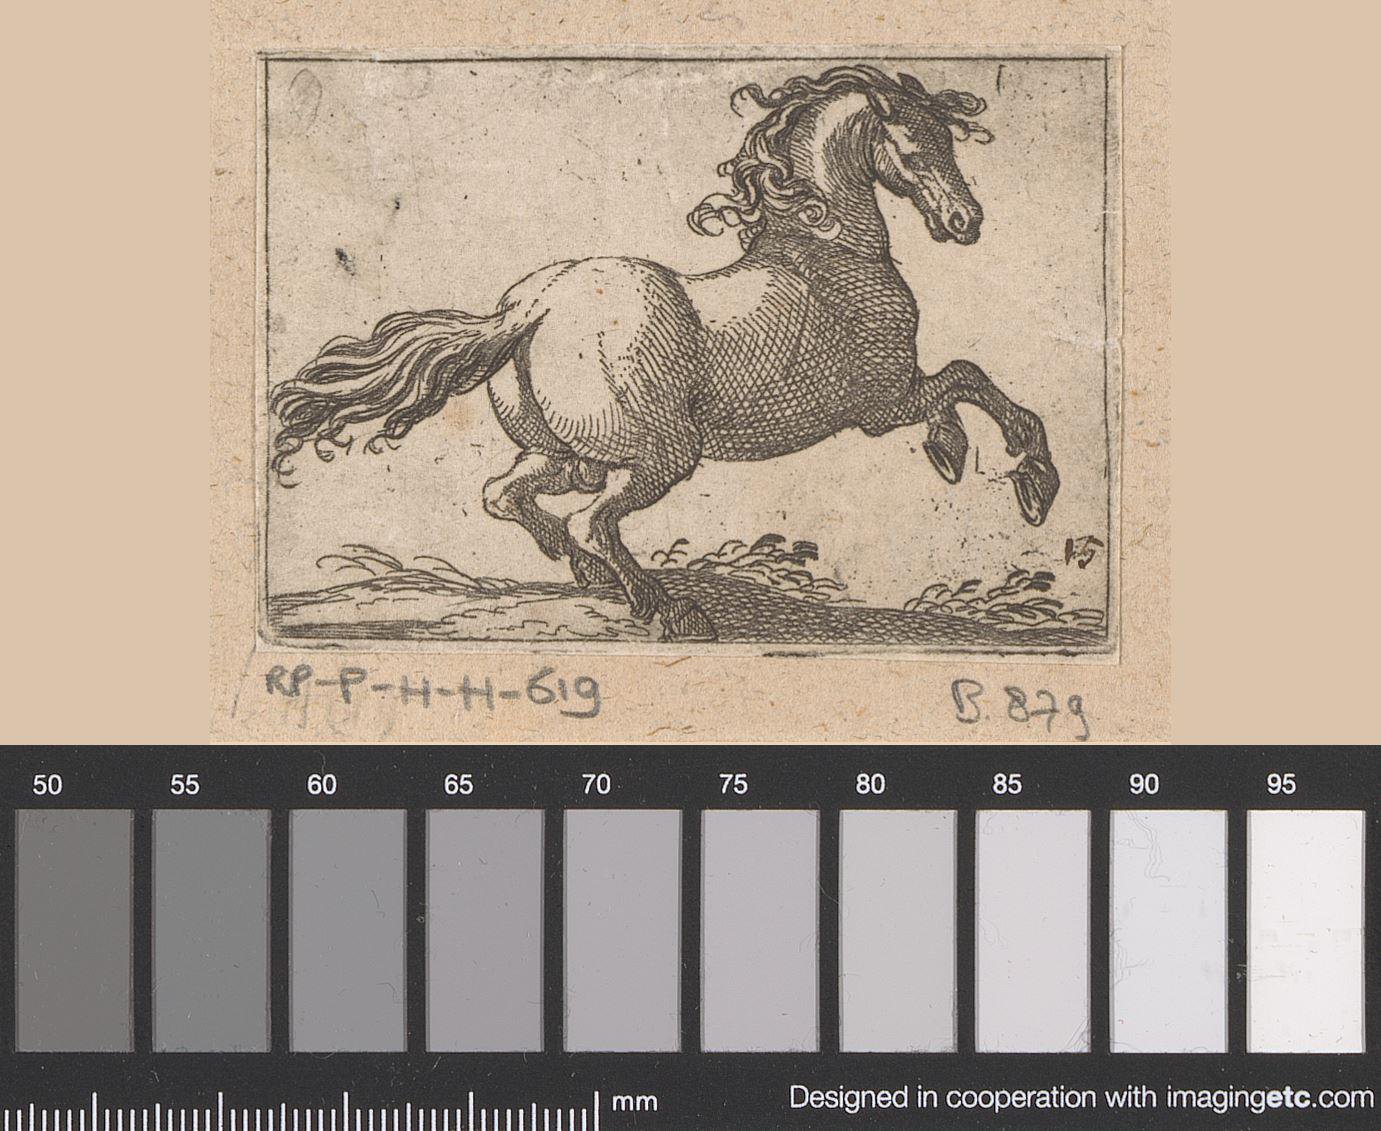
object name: print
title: Paarden in verschillende houdingen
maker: antonio tempesta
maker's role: draughtsman, painter, print maker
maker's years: 1555-1630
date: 1565-1630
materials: paper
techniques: etching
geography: italy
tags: horse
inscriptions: number: ‘15’, collector's mark: Lugt 11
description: Deze prent maakt deel uit van een reeks van 24 prenten van paarden.